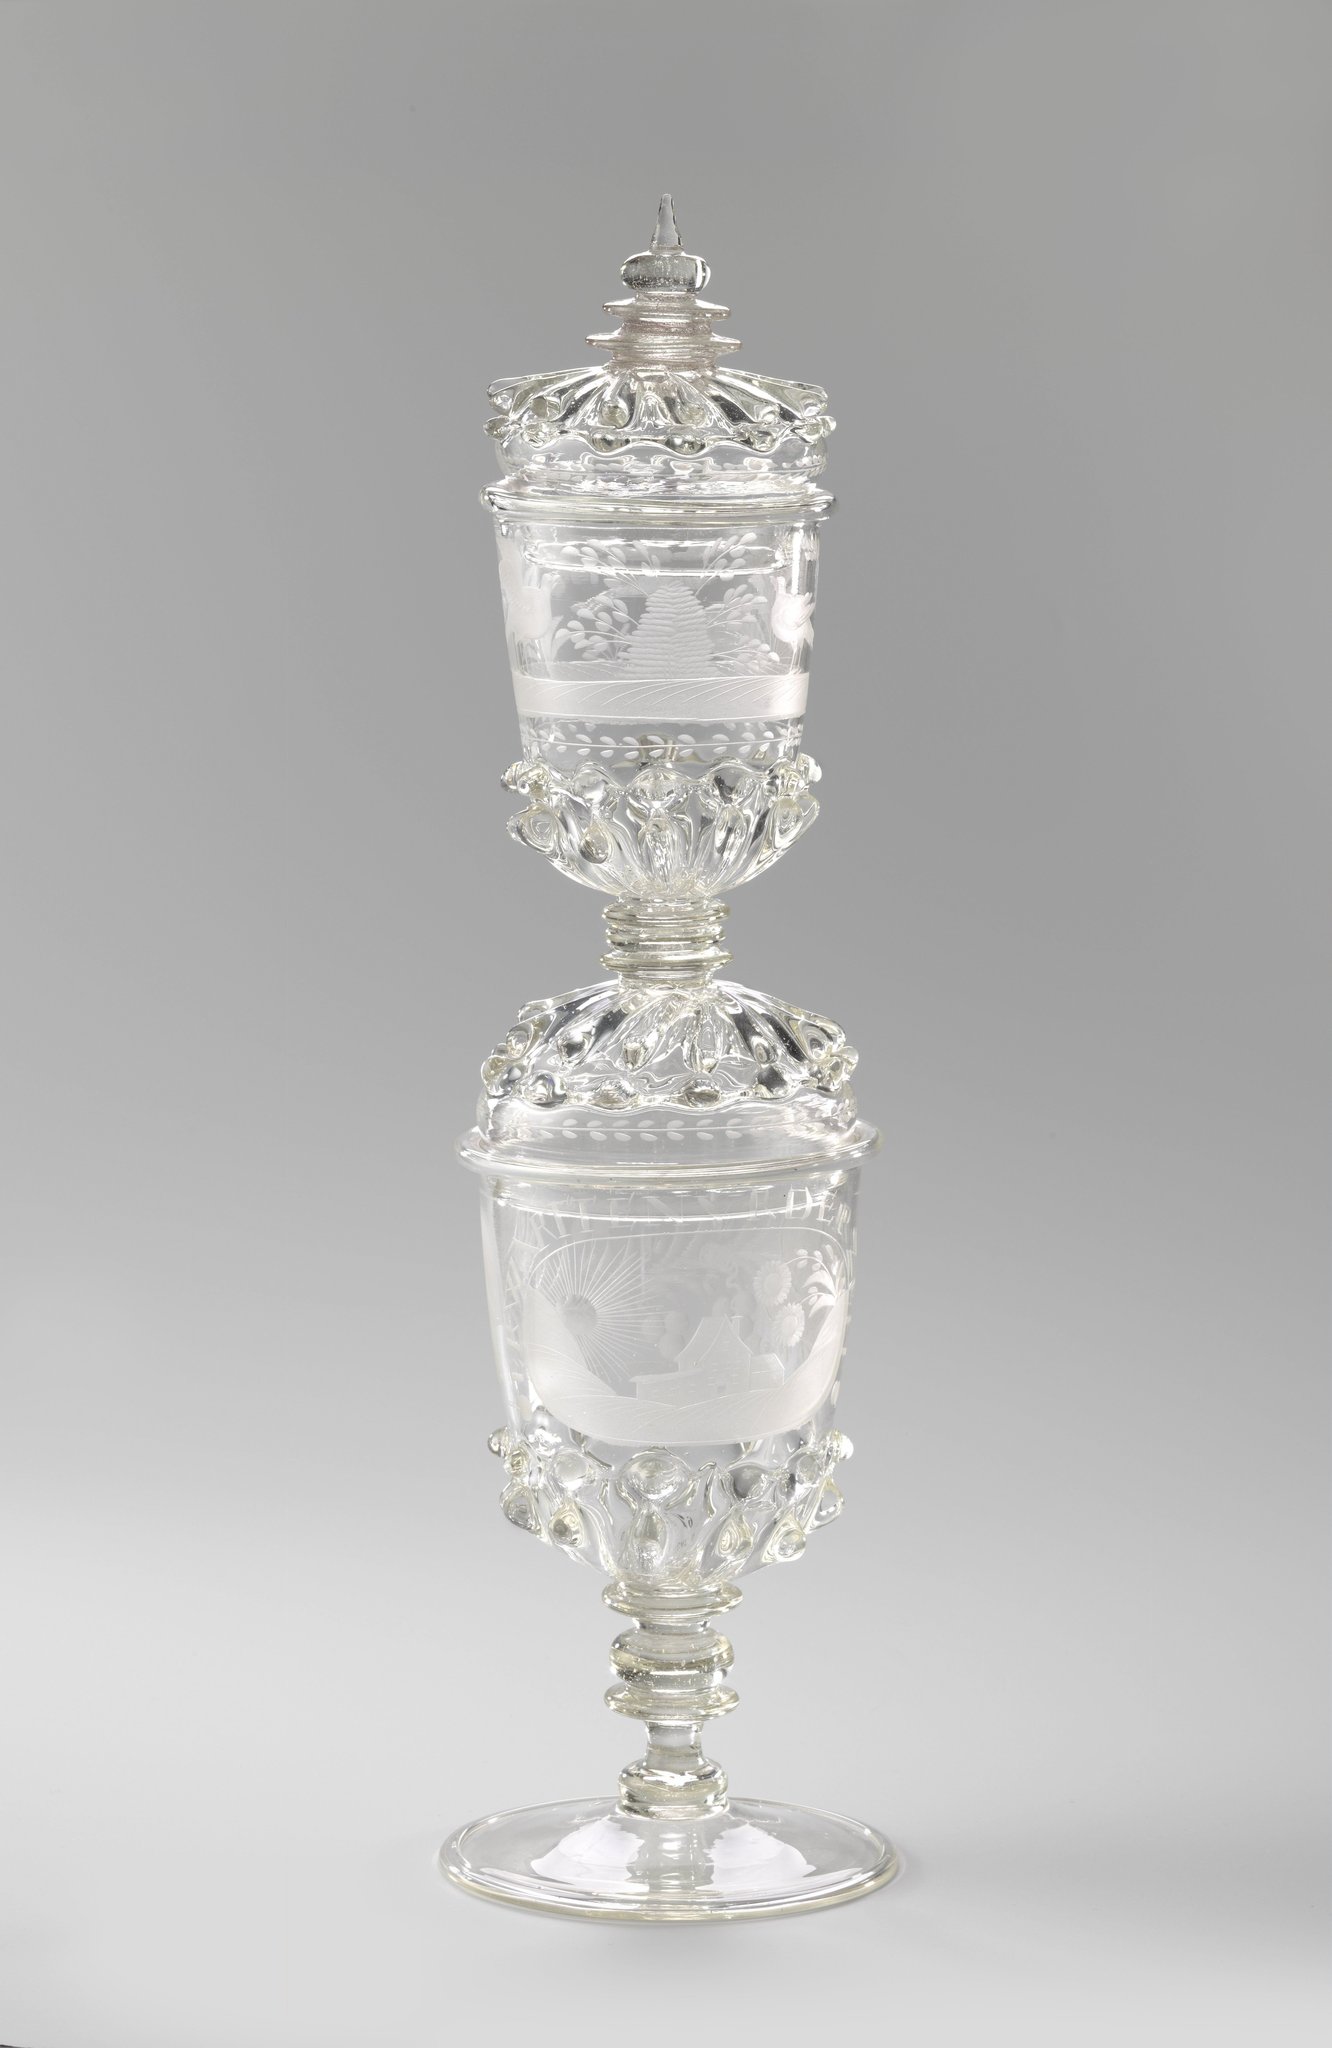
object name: goblet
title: Bokaal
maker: Anonymous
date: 1690-1700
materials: glass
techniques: glassblowing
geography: bohemia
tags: zierikzee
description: Onderdeel van een dubbelbokaal. De bokaal heeft een deksel (BK-NM-2122-2), dat tegelijk bokaal is waar ook een deksel op rust (BK-NM-2122-3).